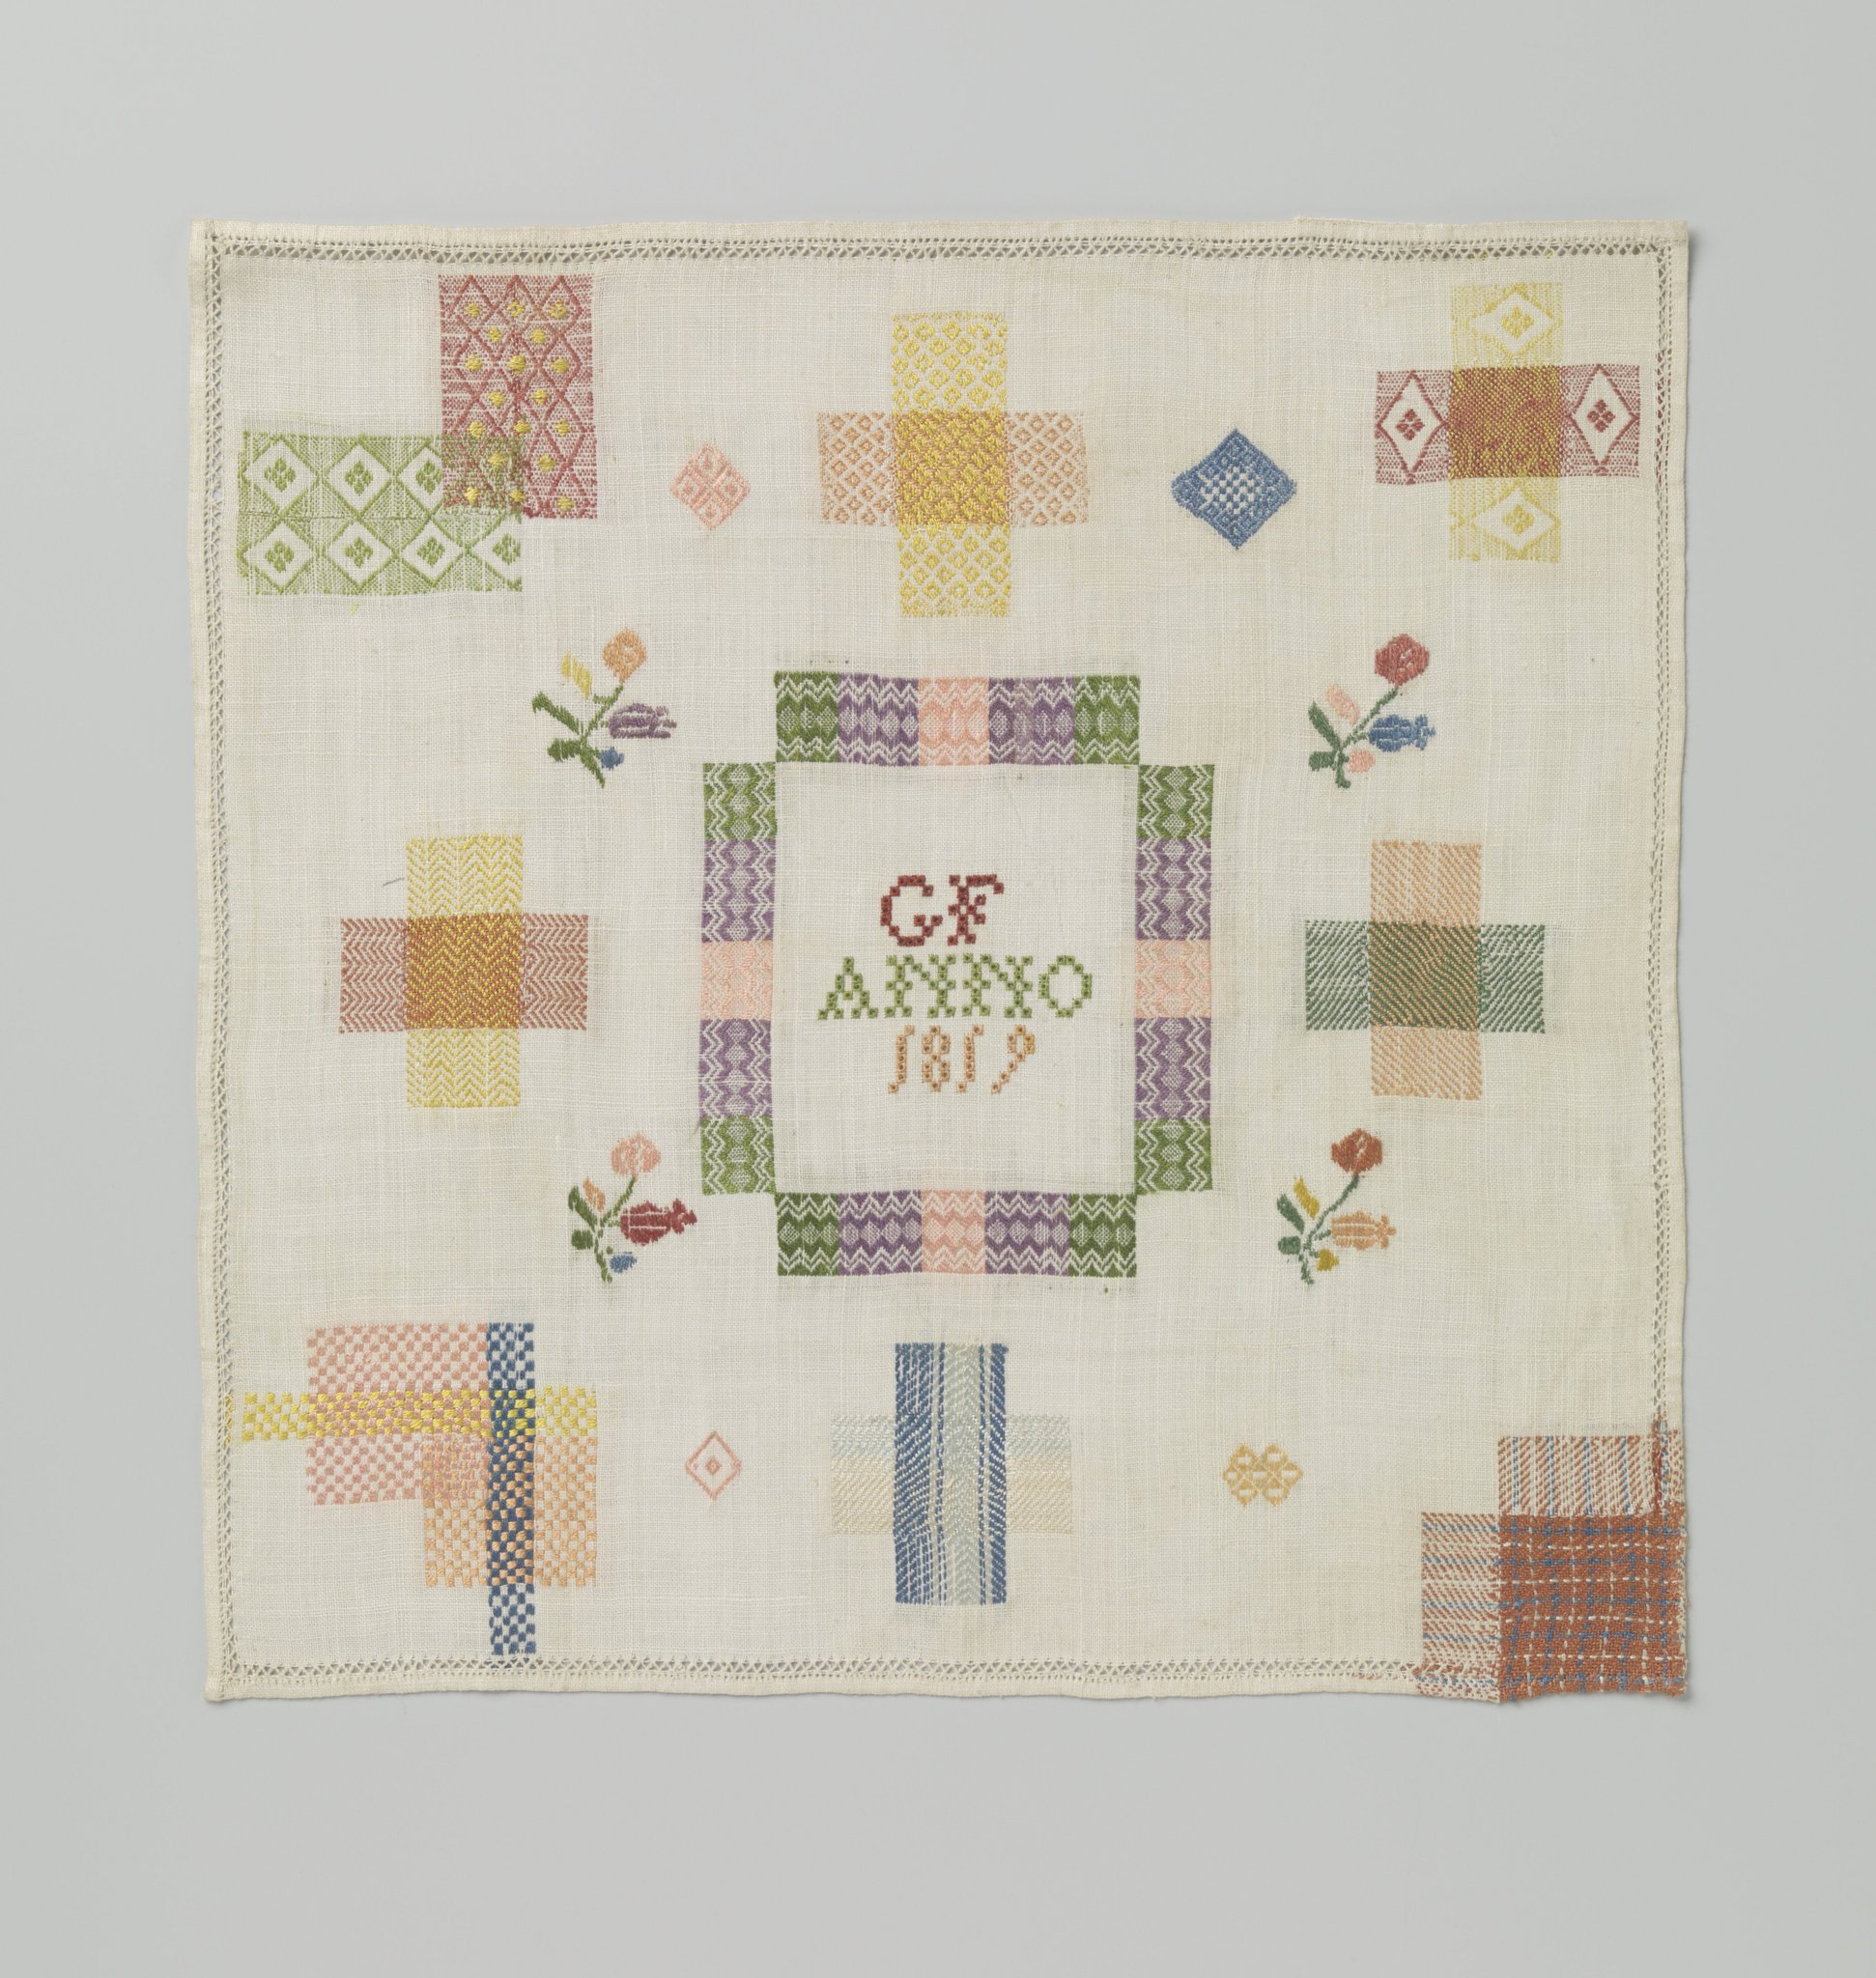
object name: stoplap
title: Stoplap met een veelkleurig borduurwerk op linnen.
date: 1819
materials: linen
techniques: embroidered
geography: netherlands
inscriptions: date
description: Stoplap met veelkleurig borduurwerk. Het borduurwerk bestaat uit een jaartal ANNO 1819 en een vierkant waarbinnen de initialen CF. In de hoeken heeft het patroon bloemmotieven.